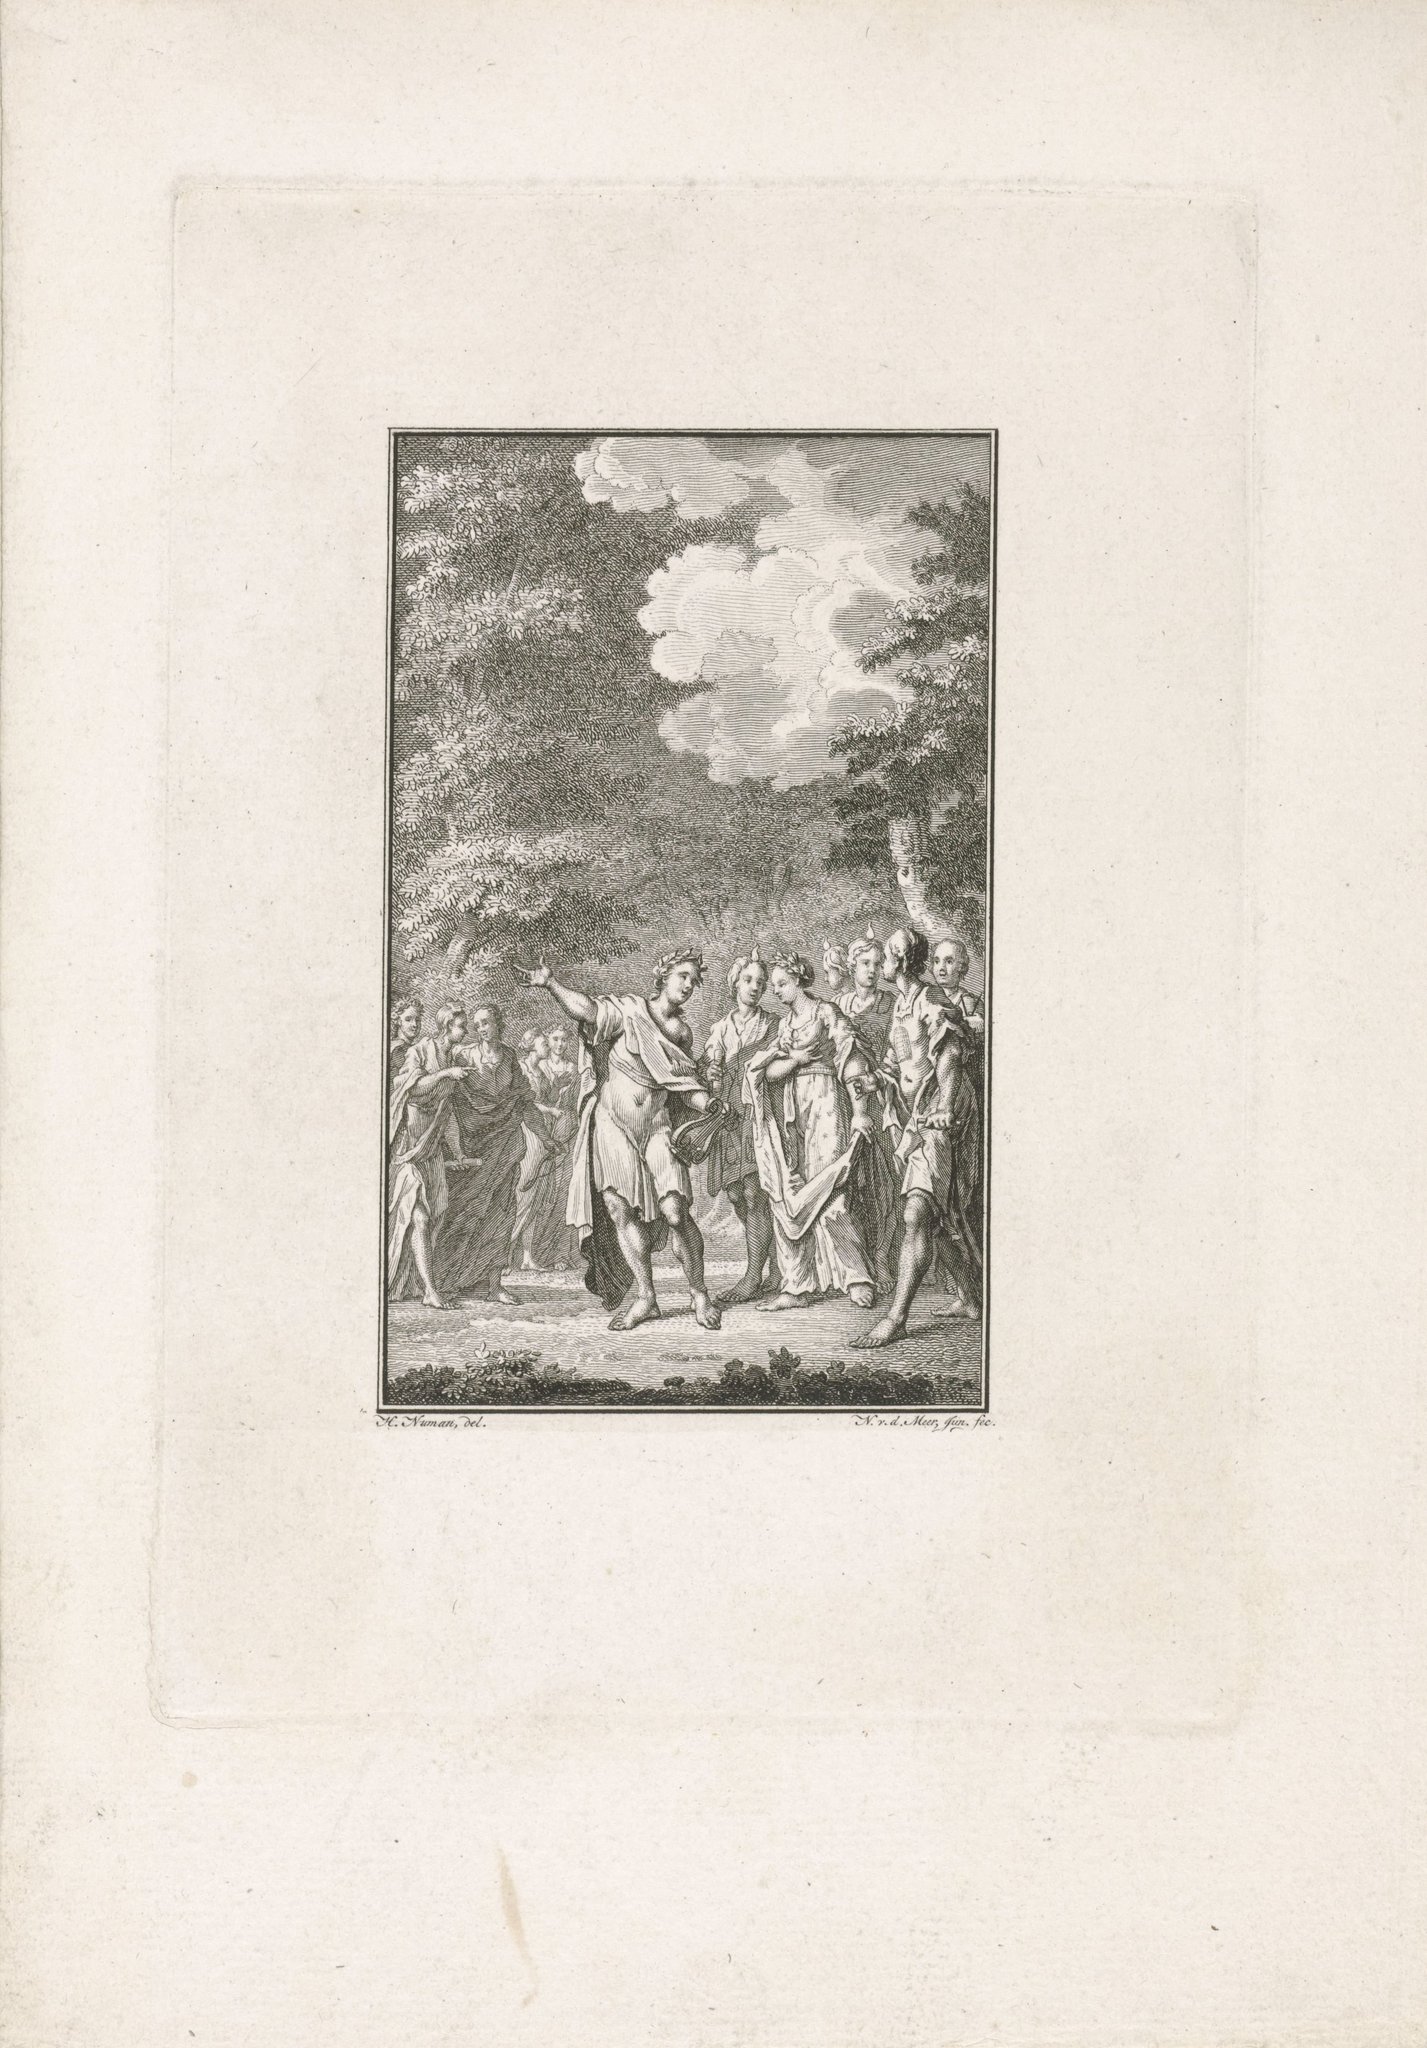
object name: print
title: Apollo en zijn volgelingen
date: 1751-1822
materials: paper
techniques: etching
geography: amsterdam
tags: (story of) apollo (phoebus), inspiration of the artist (in general), single muses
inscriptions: collector's mark: Lugt 2228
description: Apollo met een lier in zijn hand staande in het bos. Rechts een van de muzen en vrouwen met de vlam van inspiratie op het hoofd. Links de godin Diana met een boog in haar handen.